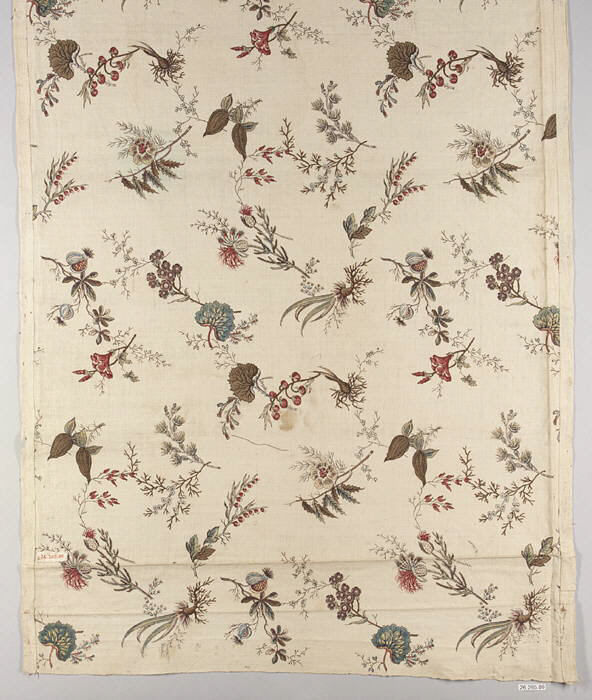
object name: piece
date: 1785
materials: linen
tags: flowers,leaves